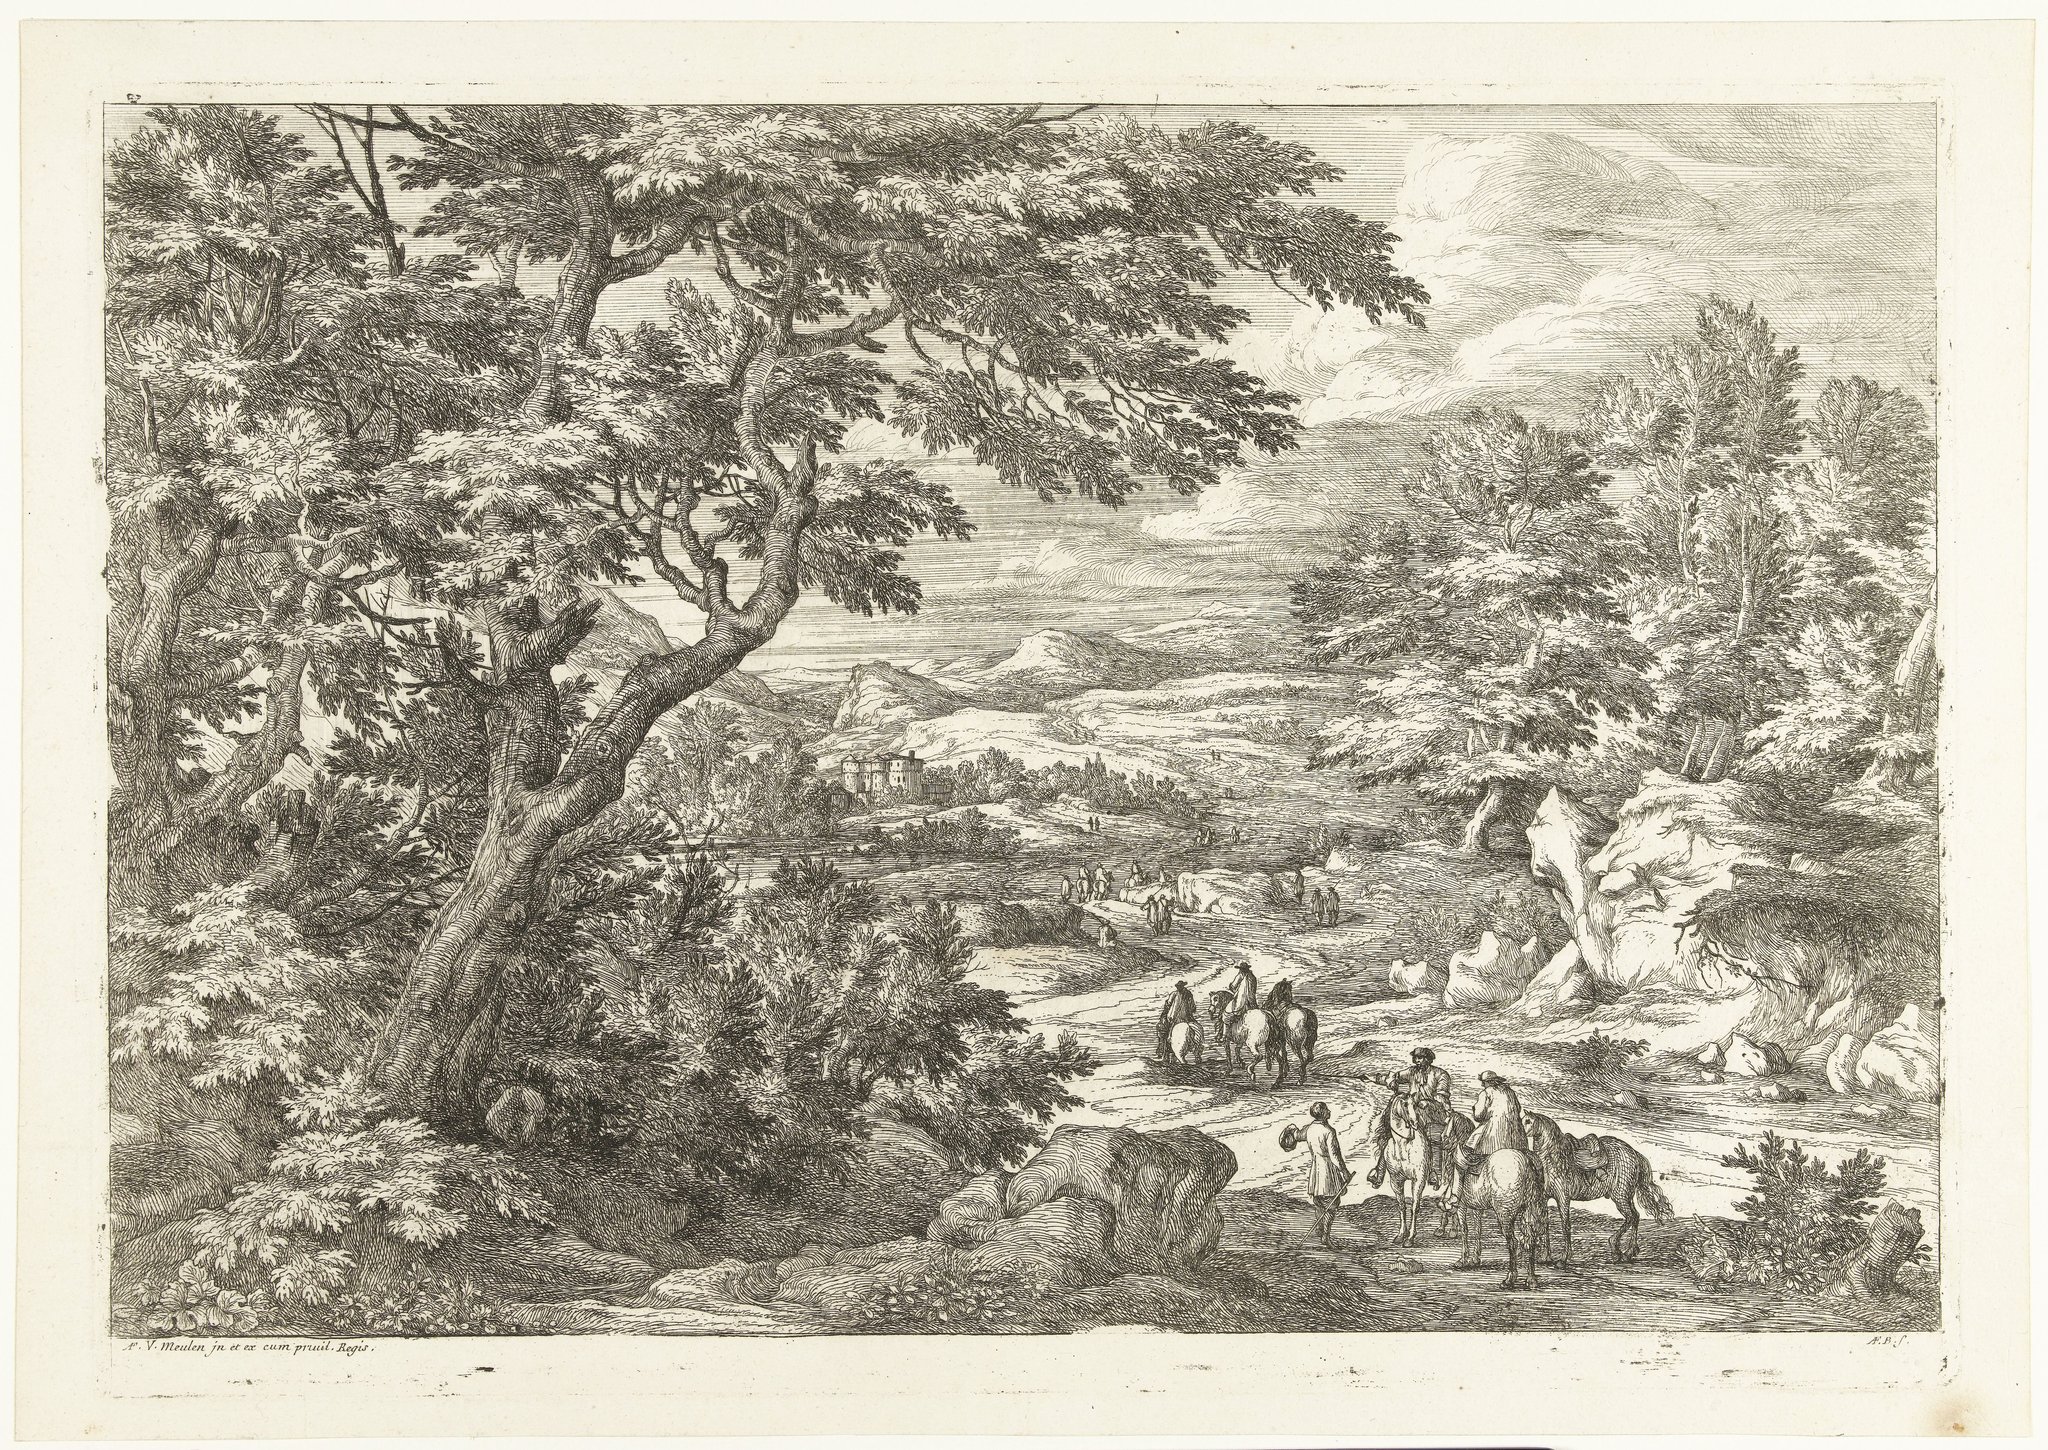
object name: print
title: Landschappen met jagers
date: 1666-1681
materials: paper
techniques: etching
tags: hunting dogs, hunting-seat, hunting lodge, 'rendez-vous de chasse', 'jagdschloss', return from the hunt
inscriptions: collector's mark: Lugt 2228